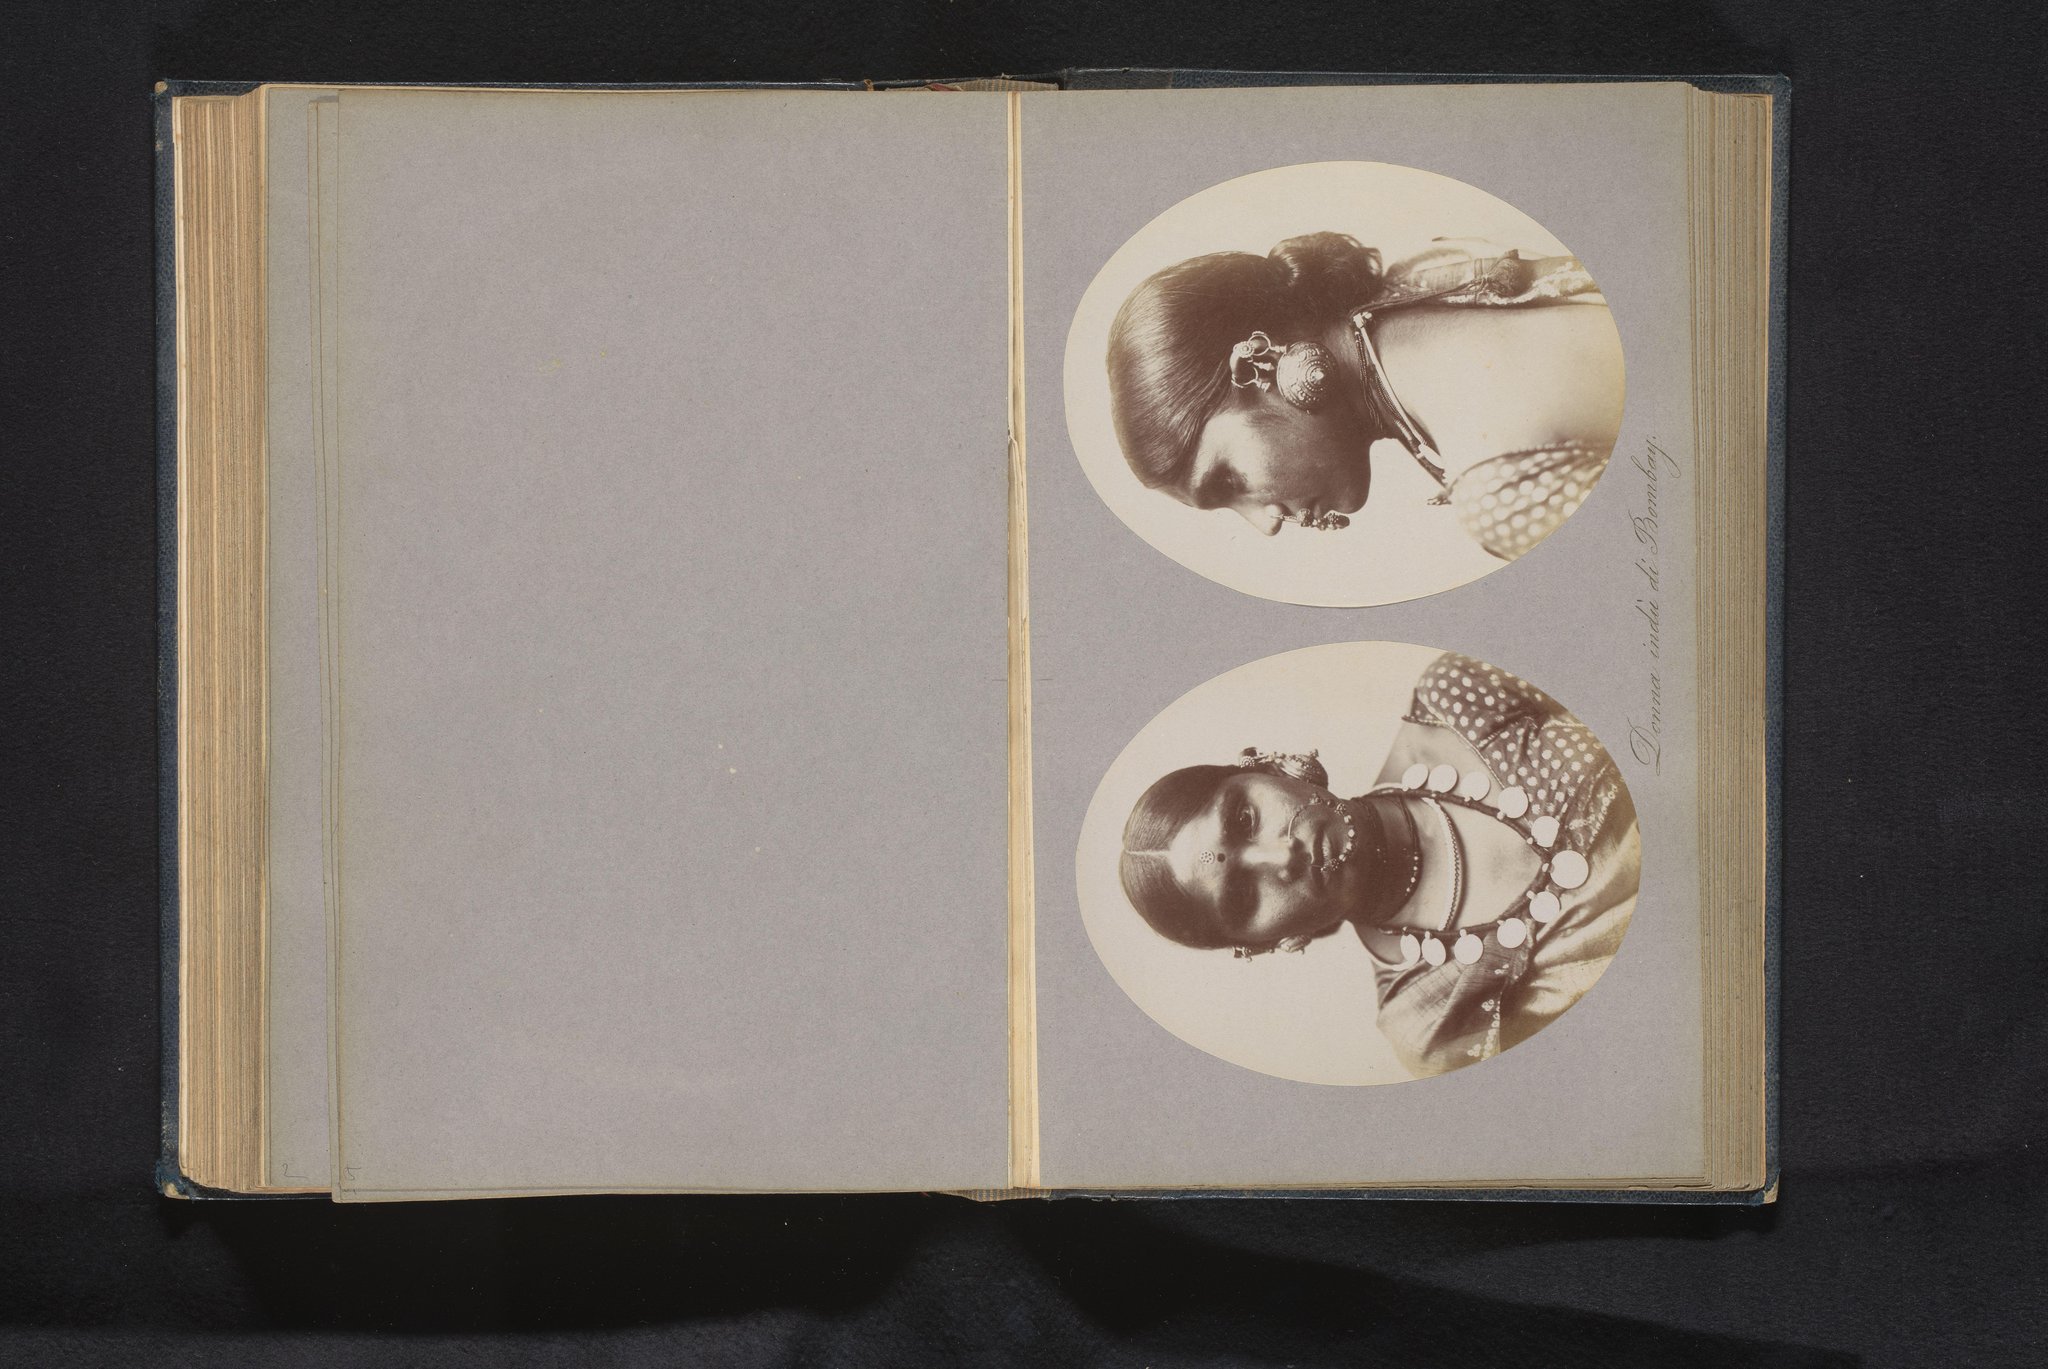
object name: page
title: Twee portretten van een onbekende vrouw met een neusring uit Madras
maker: paolo mantegazza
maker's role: antropoloog, professor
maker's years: 1831-1910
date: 1881-1886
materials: photographic support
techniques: albumen print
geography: chennai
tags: ornaments, jewels, adult woman (+ sideview, profile), adult woman (+ front view)